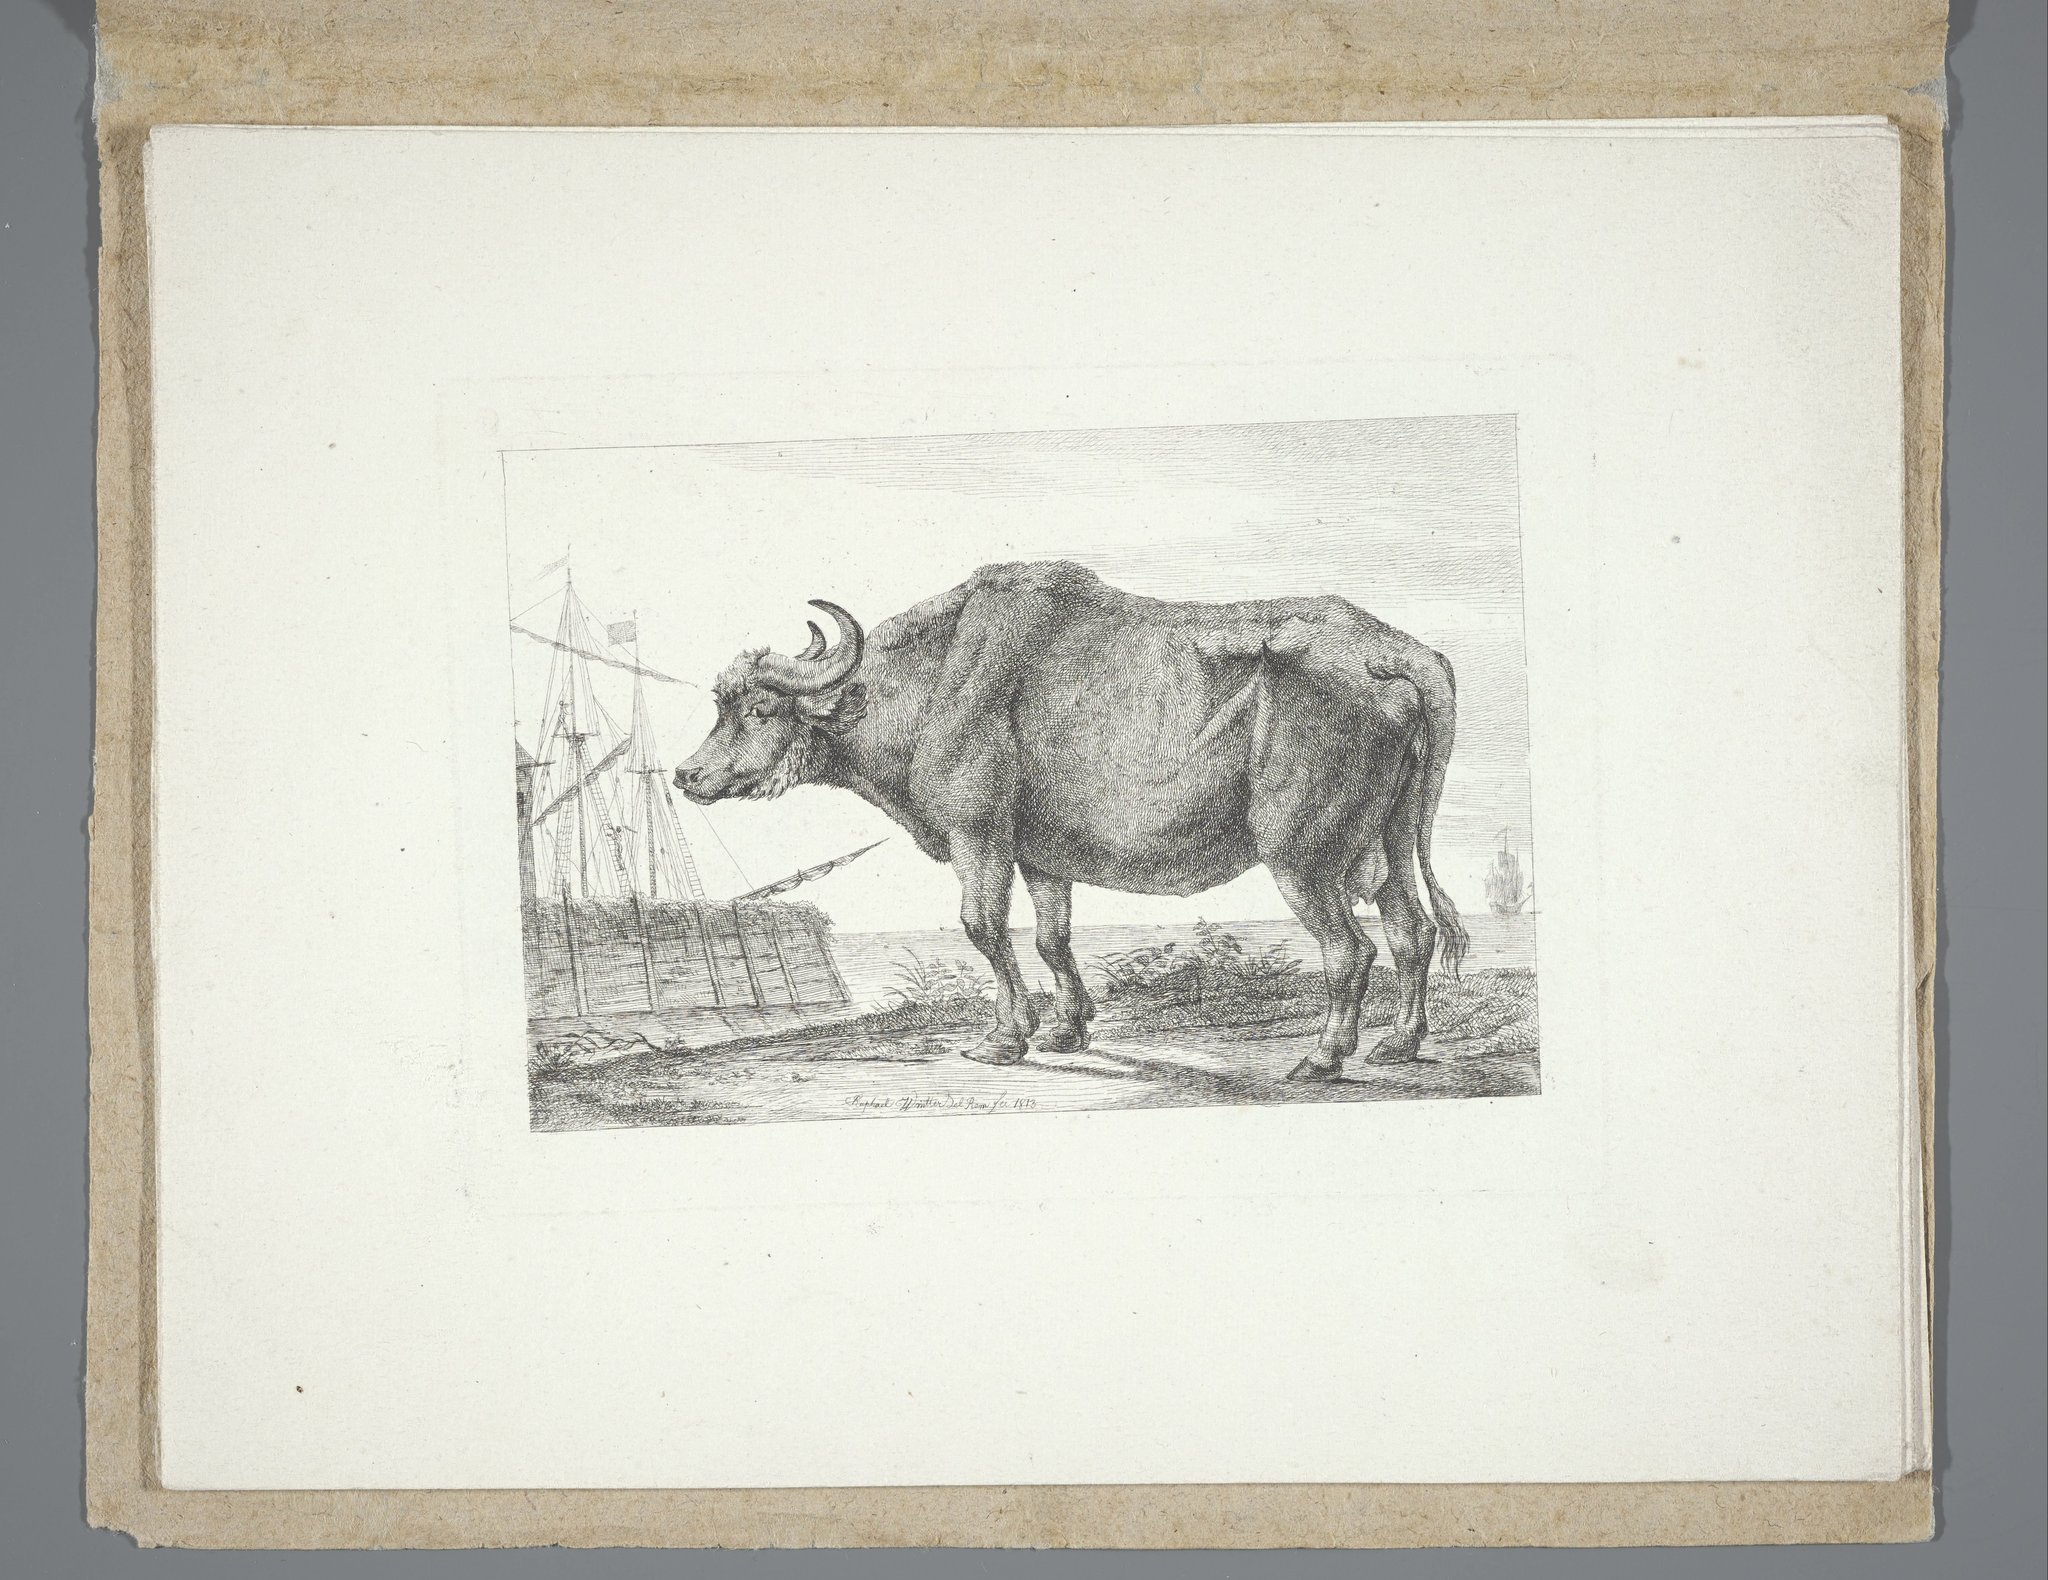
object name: print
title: Zwölf verschiedene Tieren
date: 1813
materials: paper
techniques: etching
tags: cow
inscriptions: date